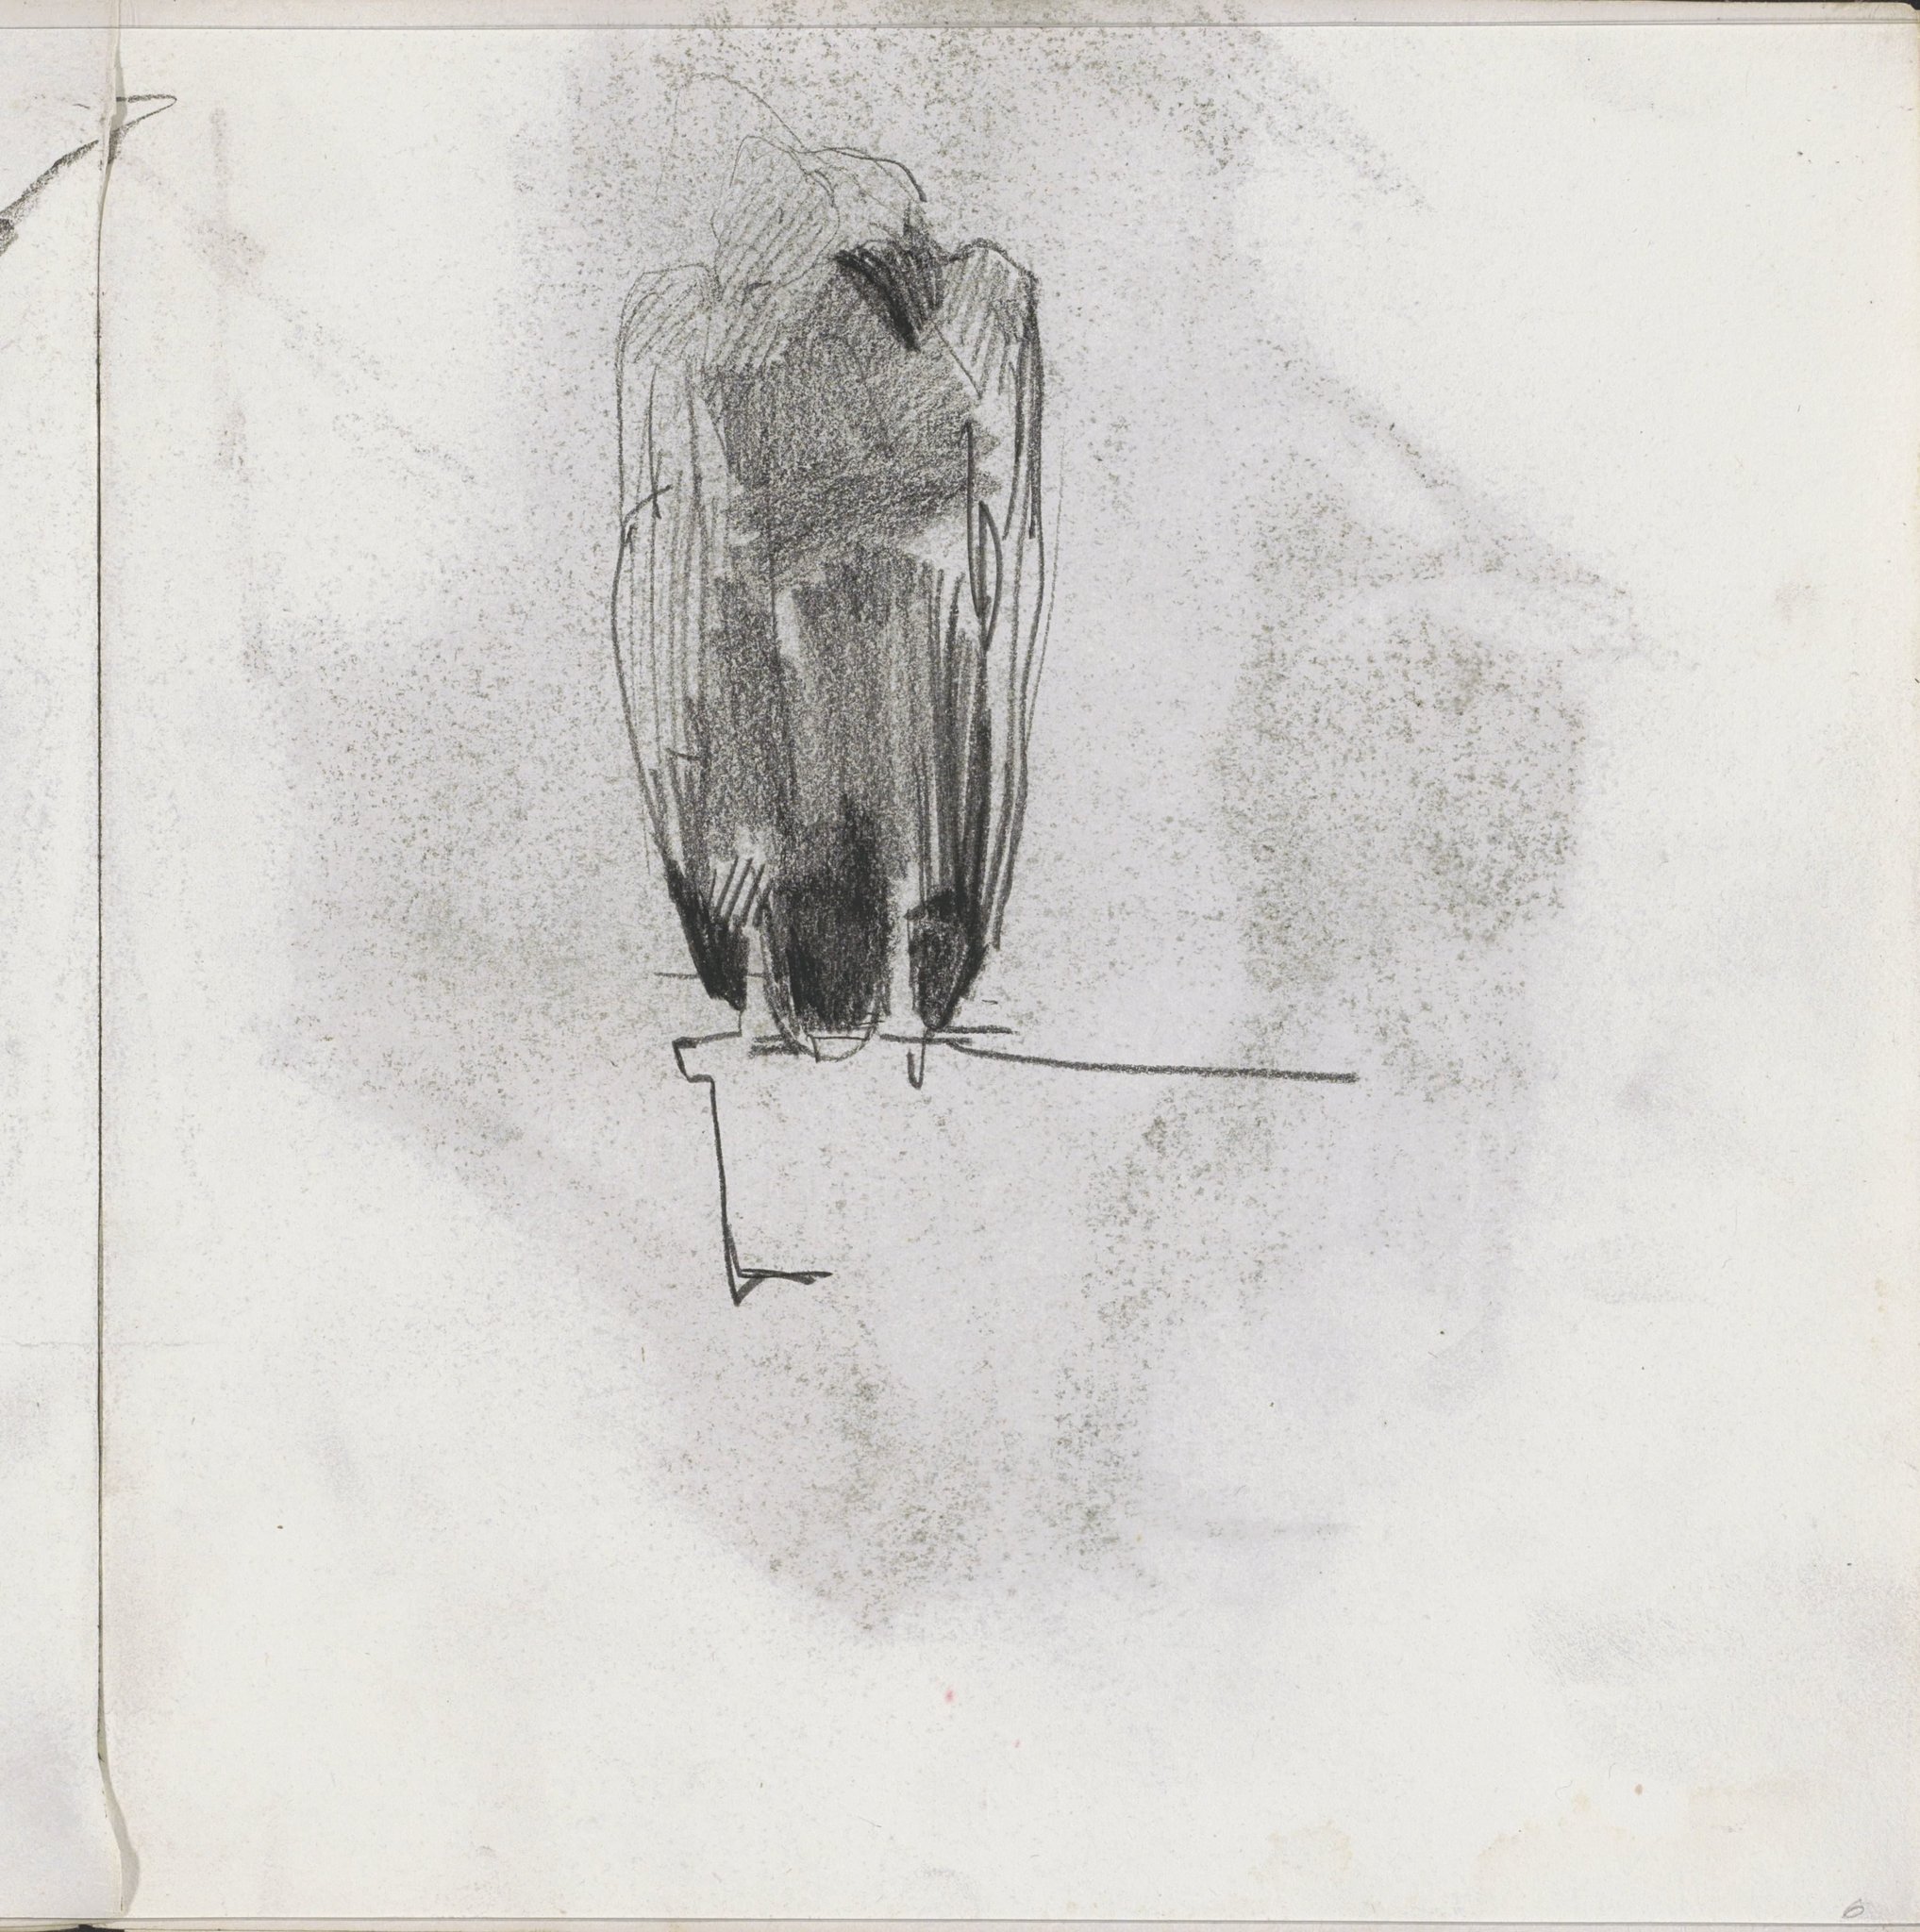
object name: sketchbook leaf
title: Vogel, mogelijk een gier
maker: isaac israels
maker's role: draughtsman, painter, print maker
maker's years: 1865-1934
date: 1875-1934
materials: chalk, paper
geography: the hague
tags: predatory birds: vulture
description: Blad 6 recto uit schetsboek IX met 28 bladen.